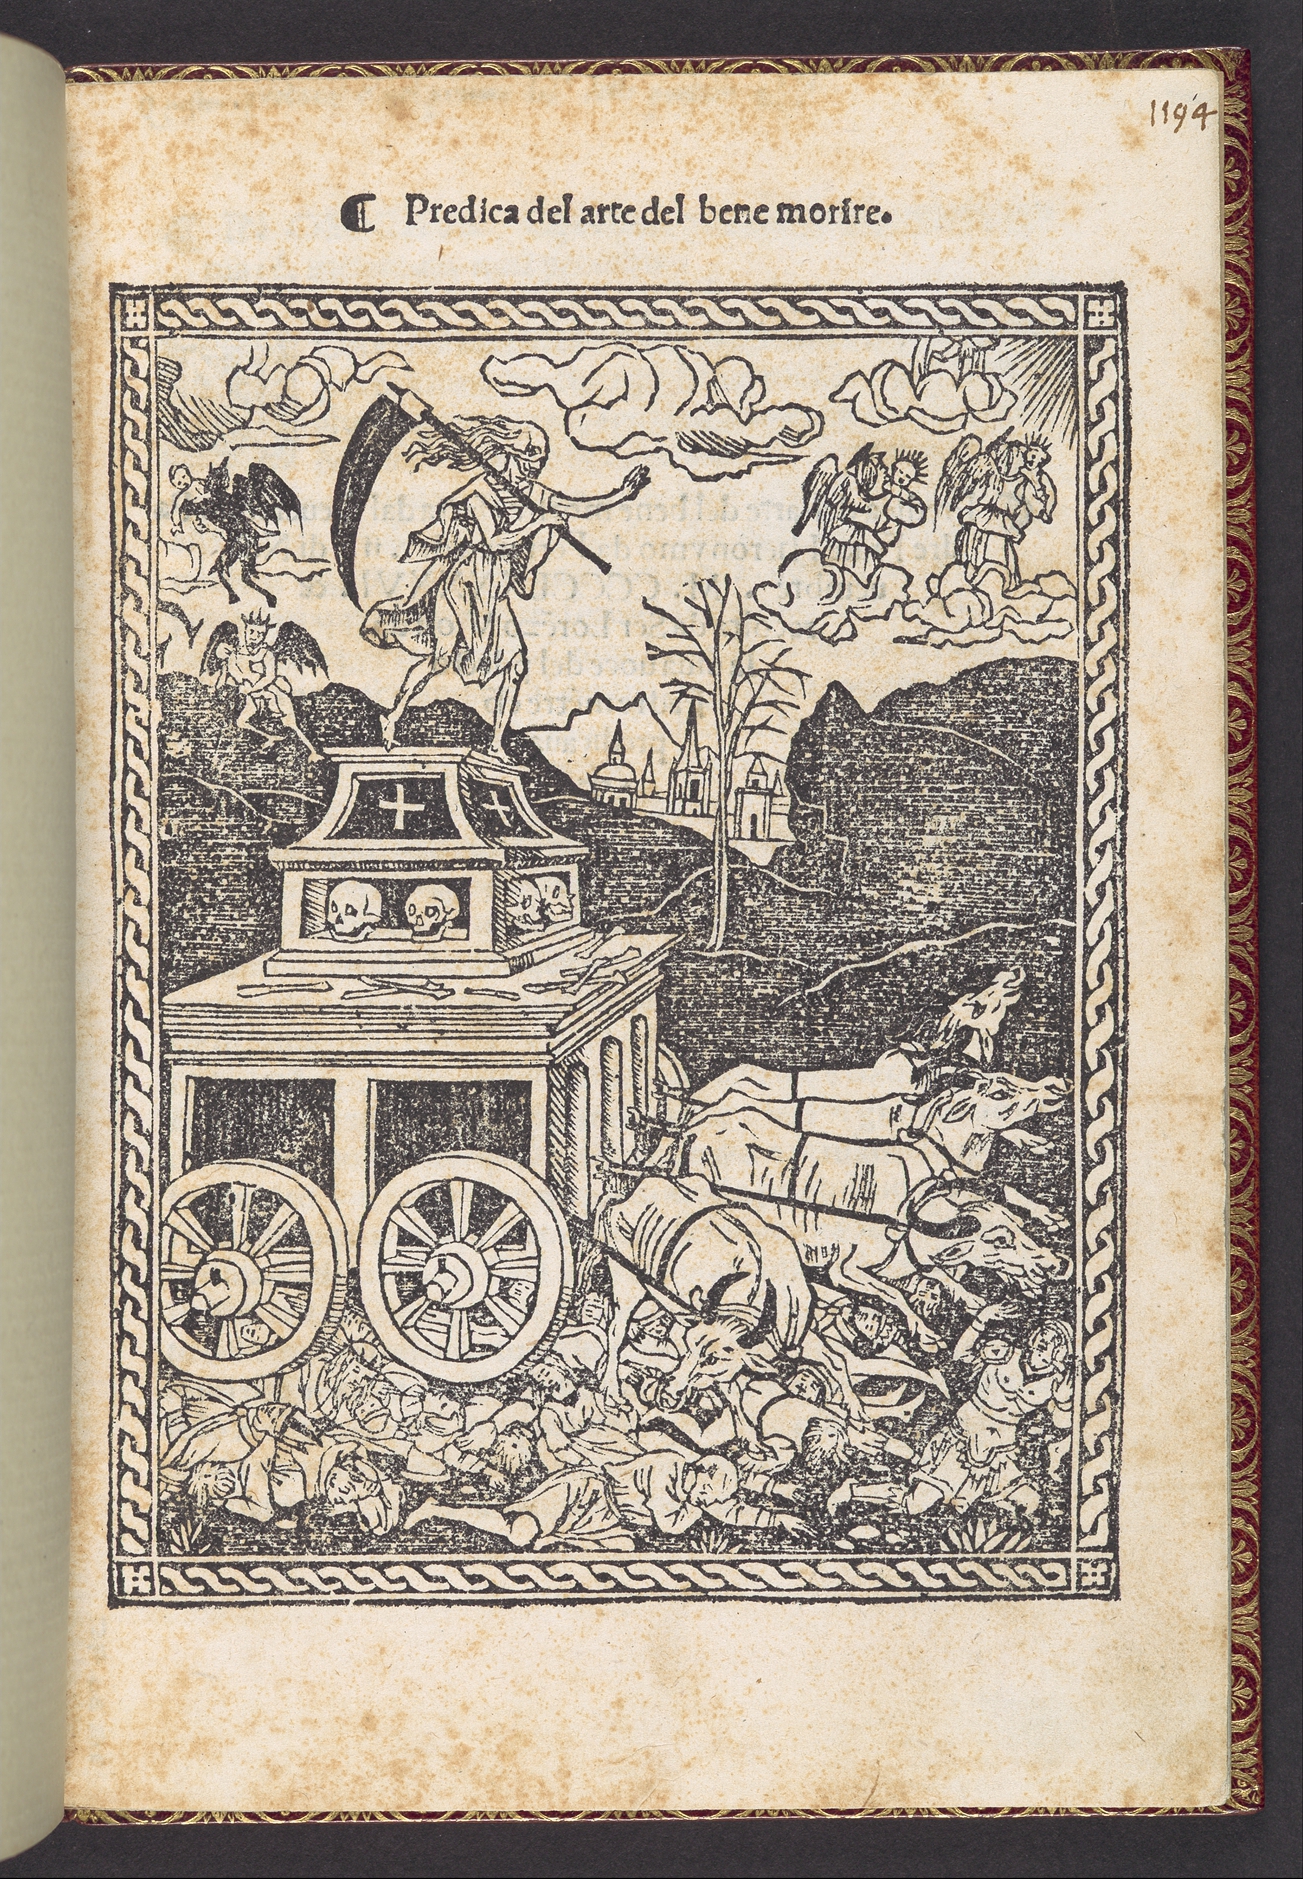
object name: book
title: Predica del arte del bene morire (sermon on the art of dying well)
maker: girolamo savonarola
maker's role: author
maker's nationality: italian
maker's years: 1452-1498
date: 1502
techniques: printing, woodcut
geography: florence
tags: skulls,bulls,angels,devil,death,chariots